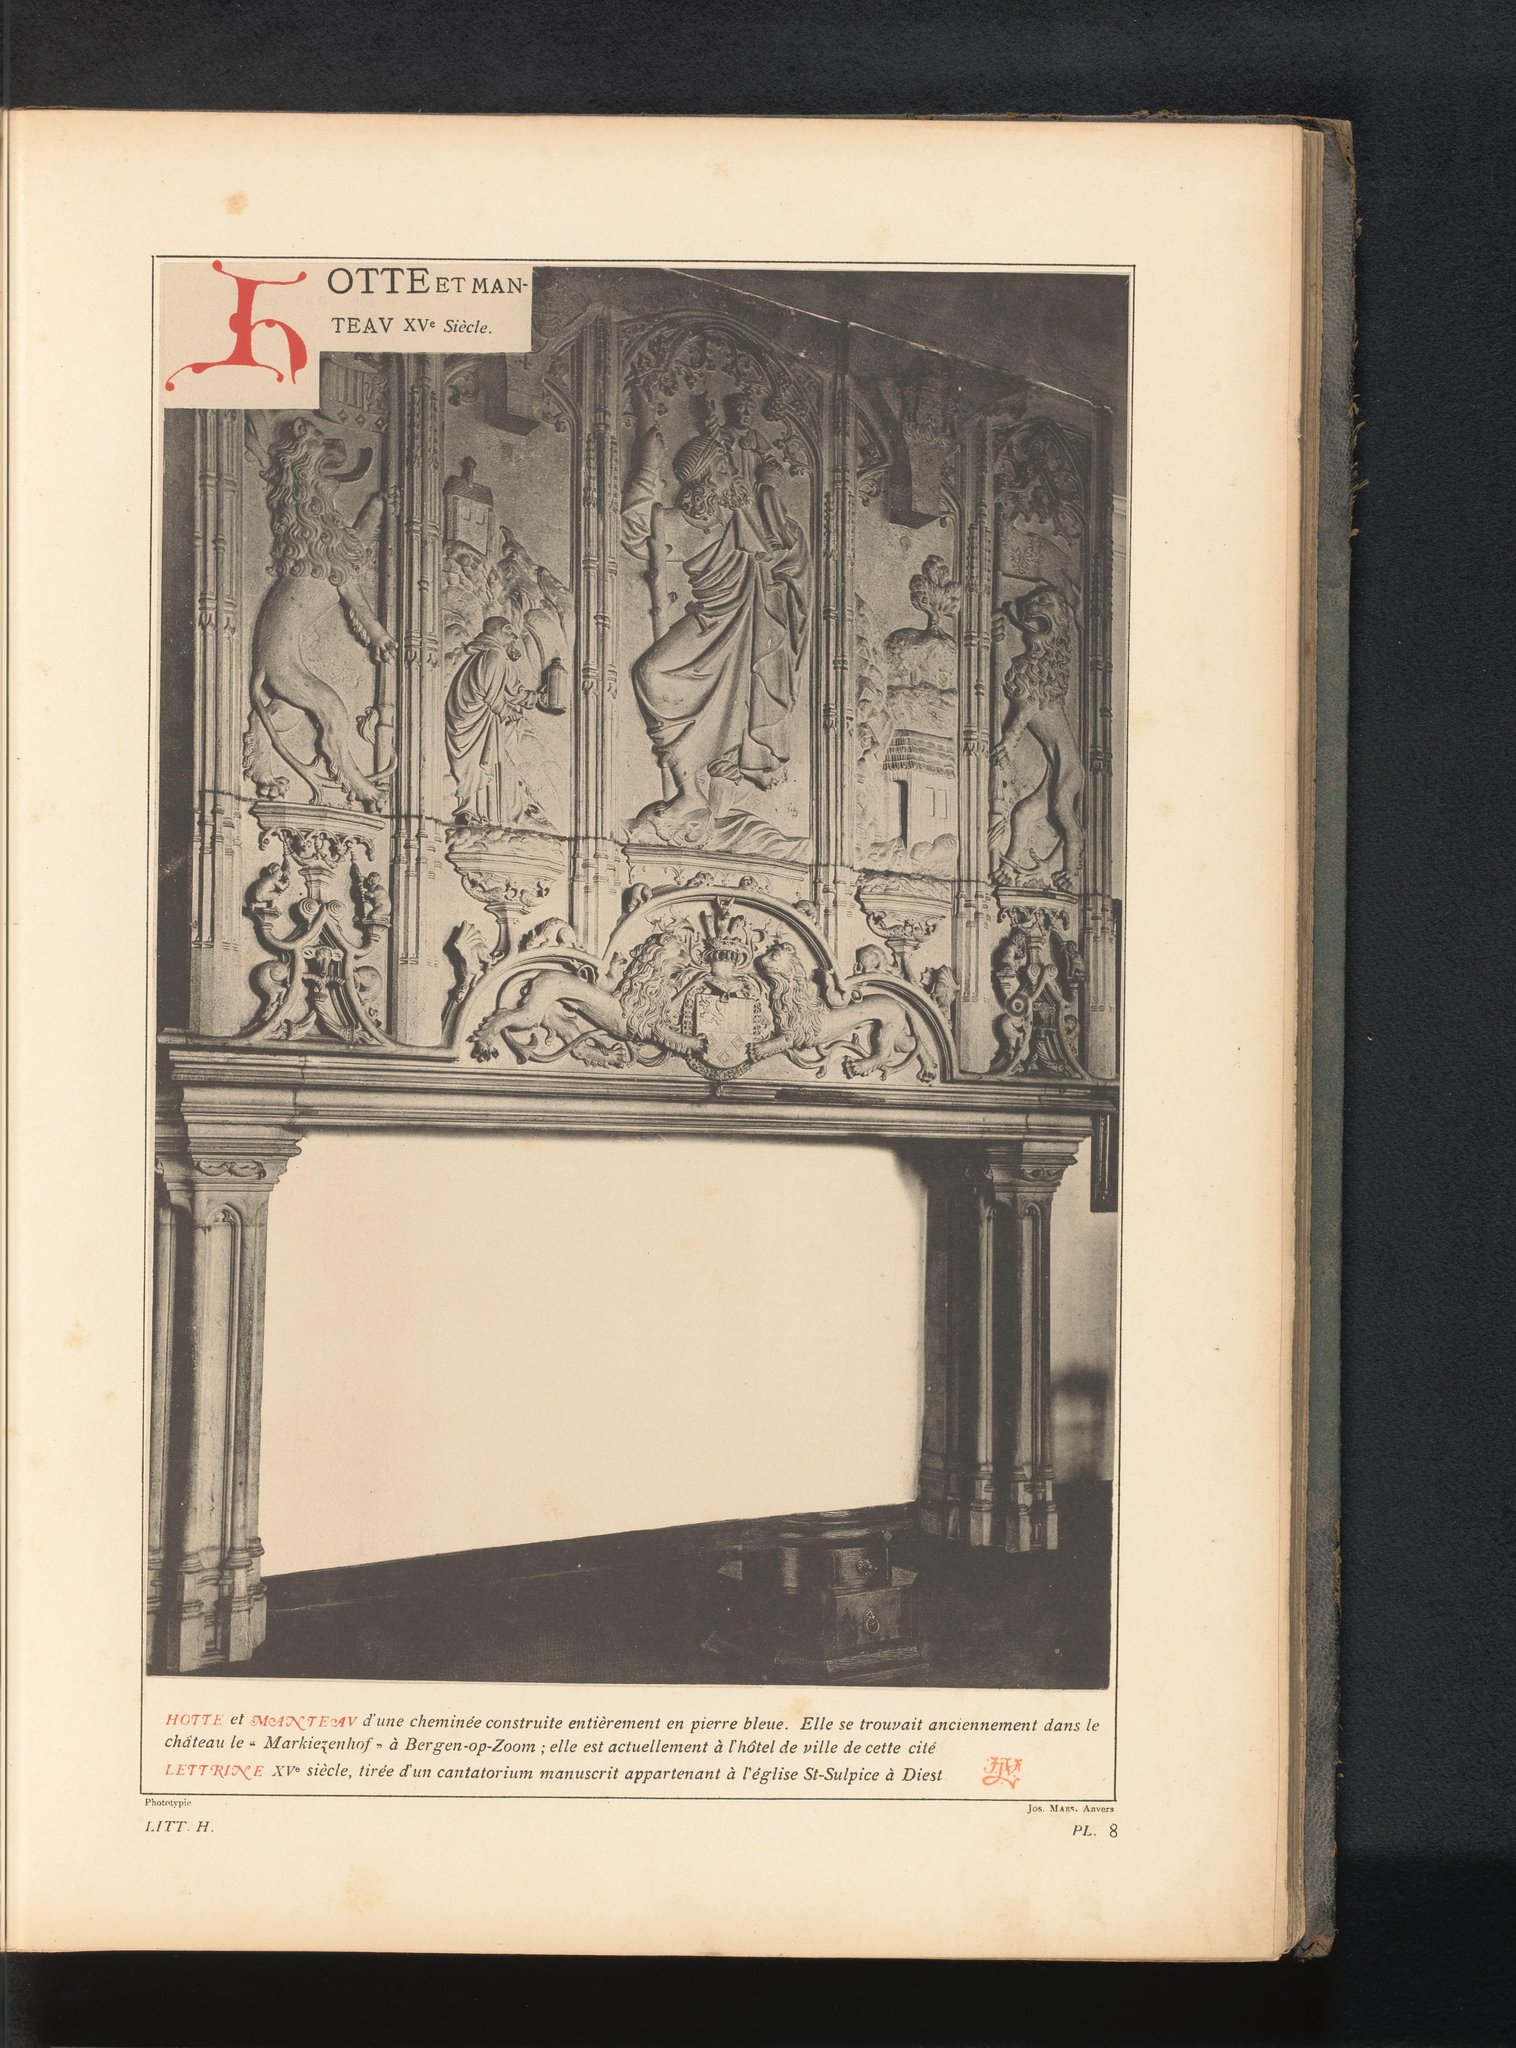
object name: page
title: Gedecoreerde schoorsteenmantel afkomstig uit het Markiezenhof, tegenwoordig in het stadhuis van Bergen-op-Zoom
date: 1875-1880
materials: paper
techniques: photograph, photolithography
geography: bergen op zoom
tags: chimney-piece, mantelpiece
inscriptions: inscription: ‘LITT. H. - PL. 8’, monogram: ‘JJvY’, inscription: ‘HOTTE et MANTEAU (...)’